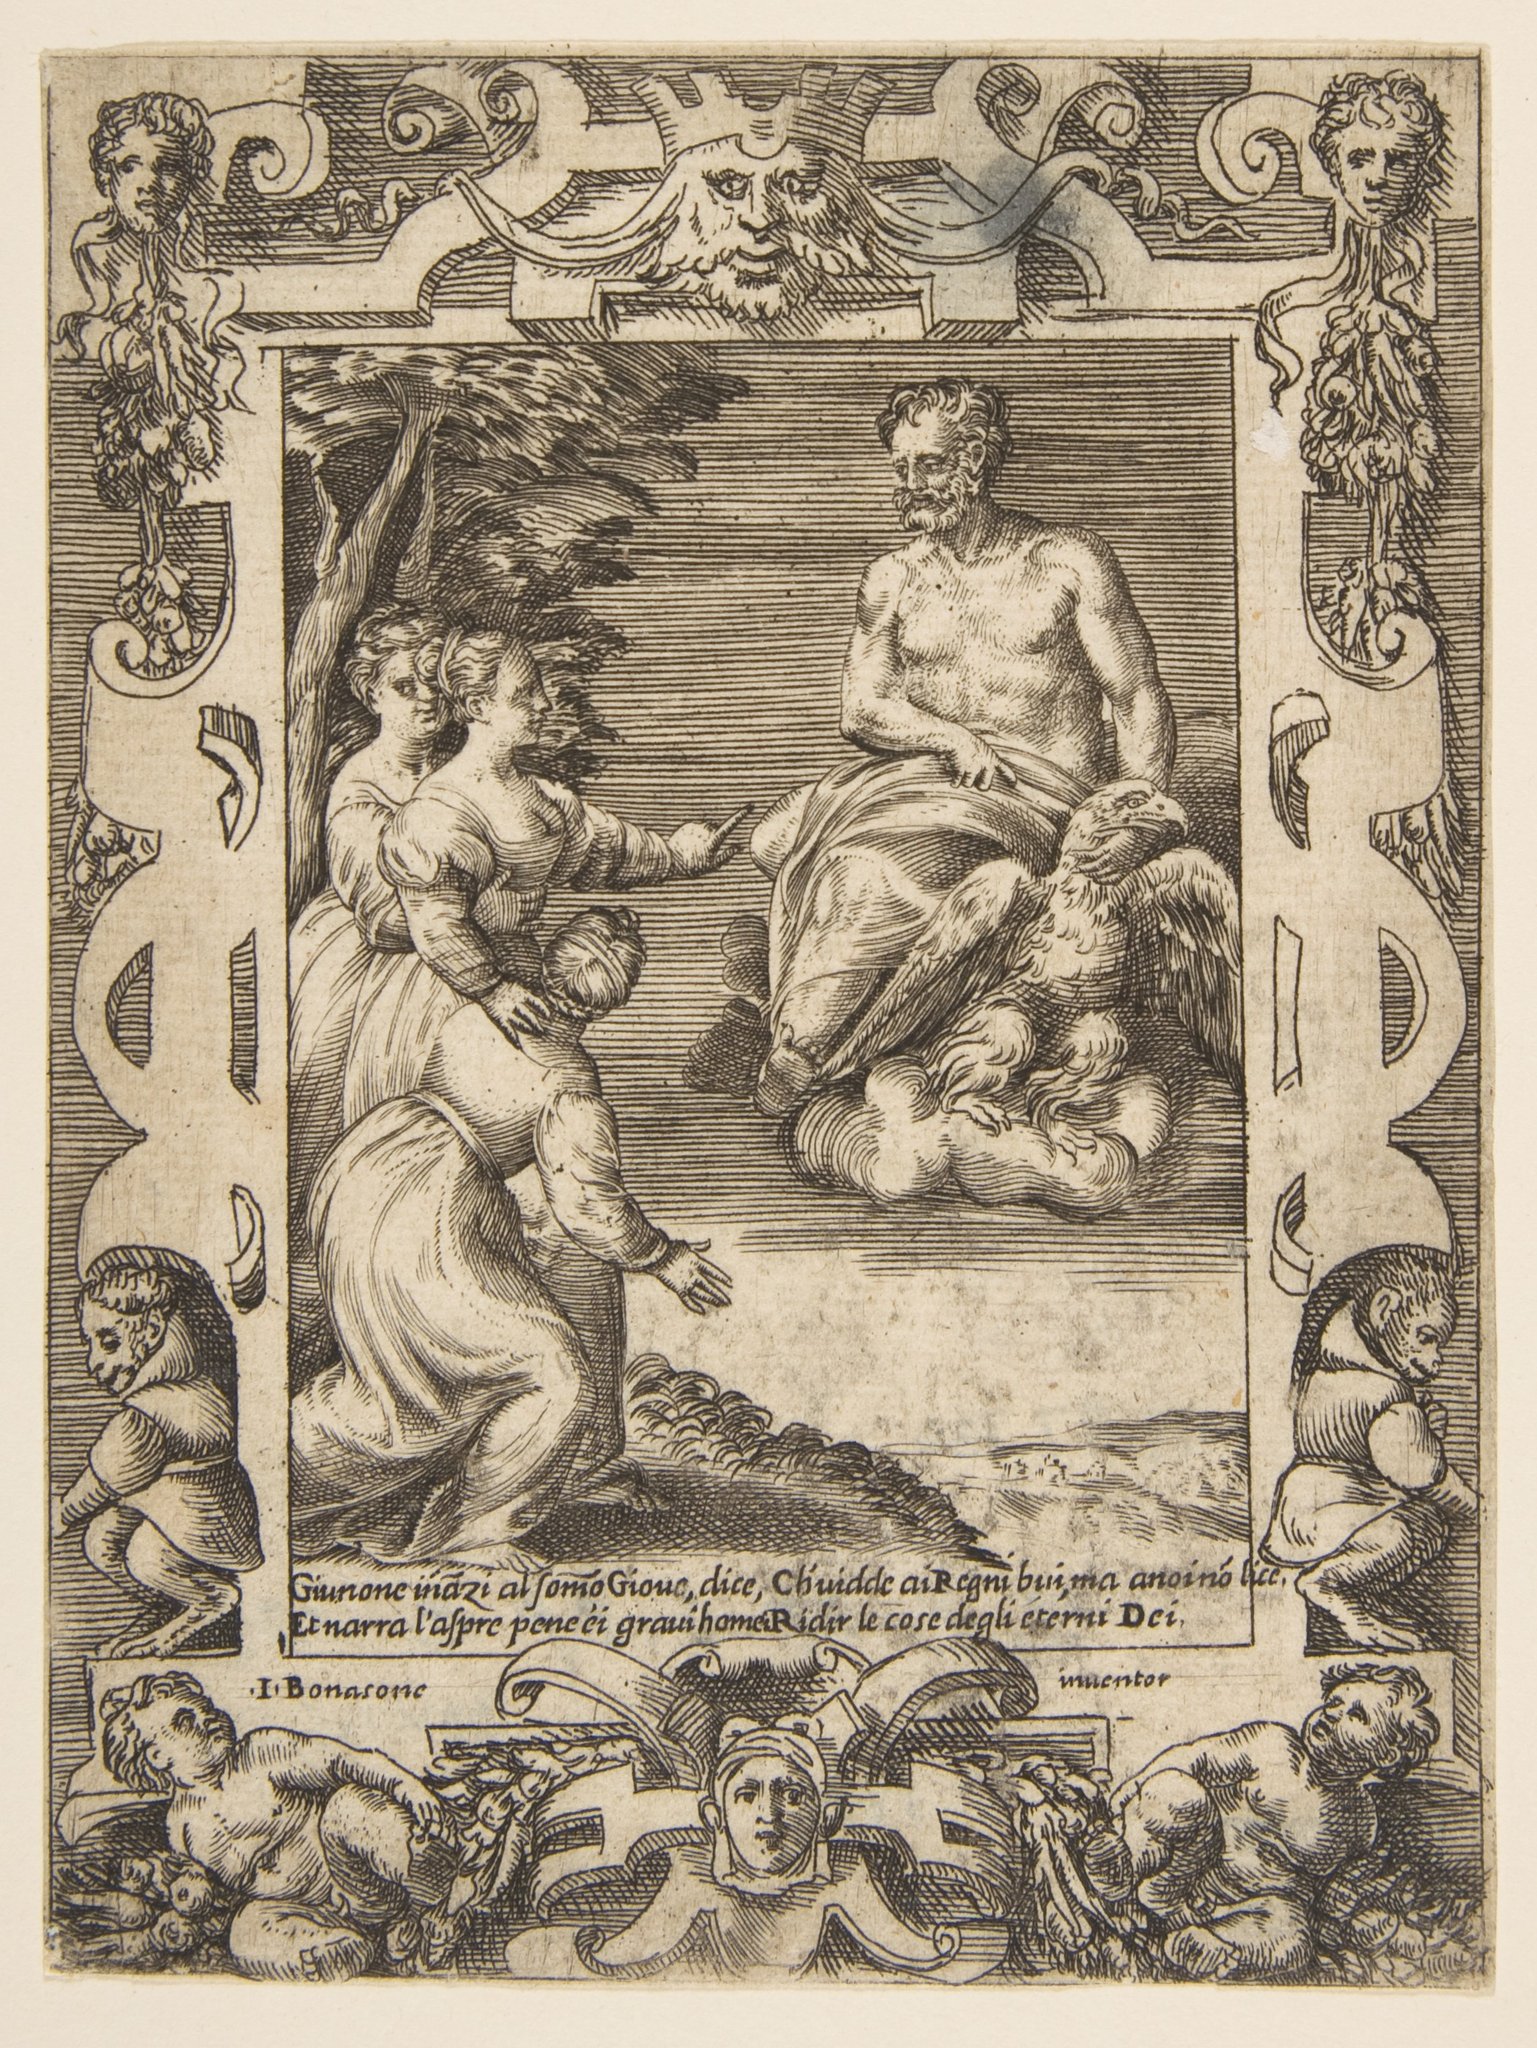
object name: print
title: Juno at left asks Jupiter to help the Greeks, set within an elaborate frame, from "Loves, Rages and Jealousies of Juno"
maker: giulio bonasone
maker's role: artist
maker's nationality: italian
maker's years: 1510-1576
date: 1531-1576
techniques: engraving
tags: juno,jupiter